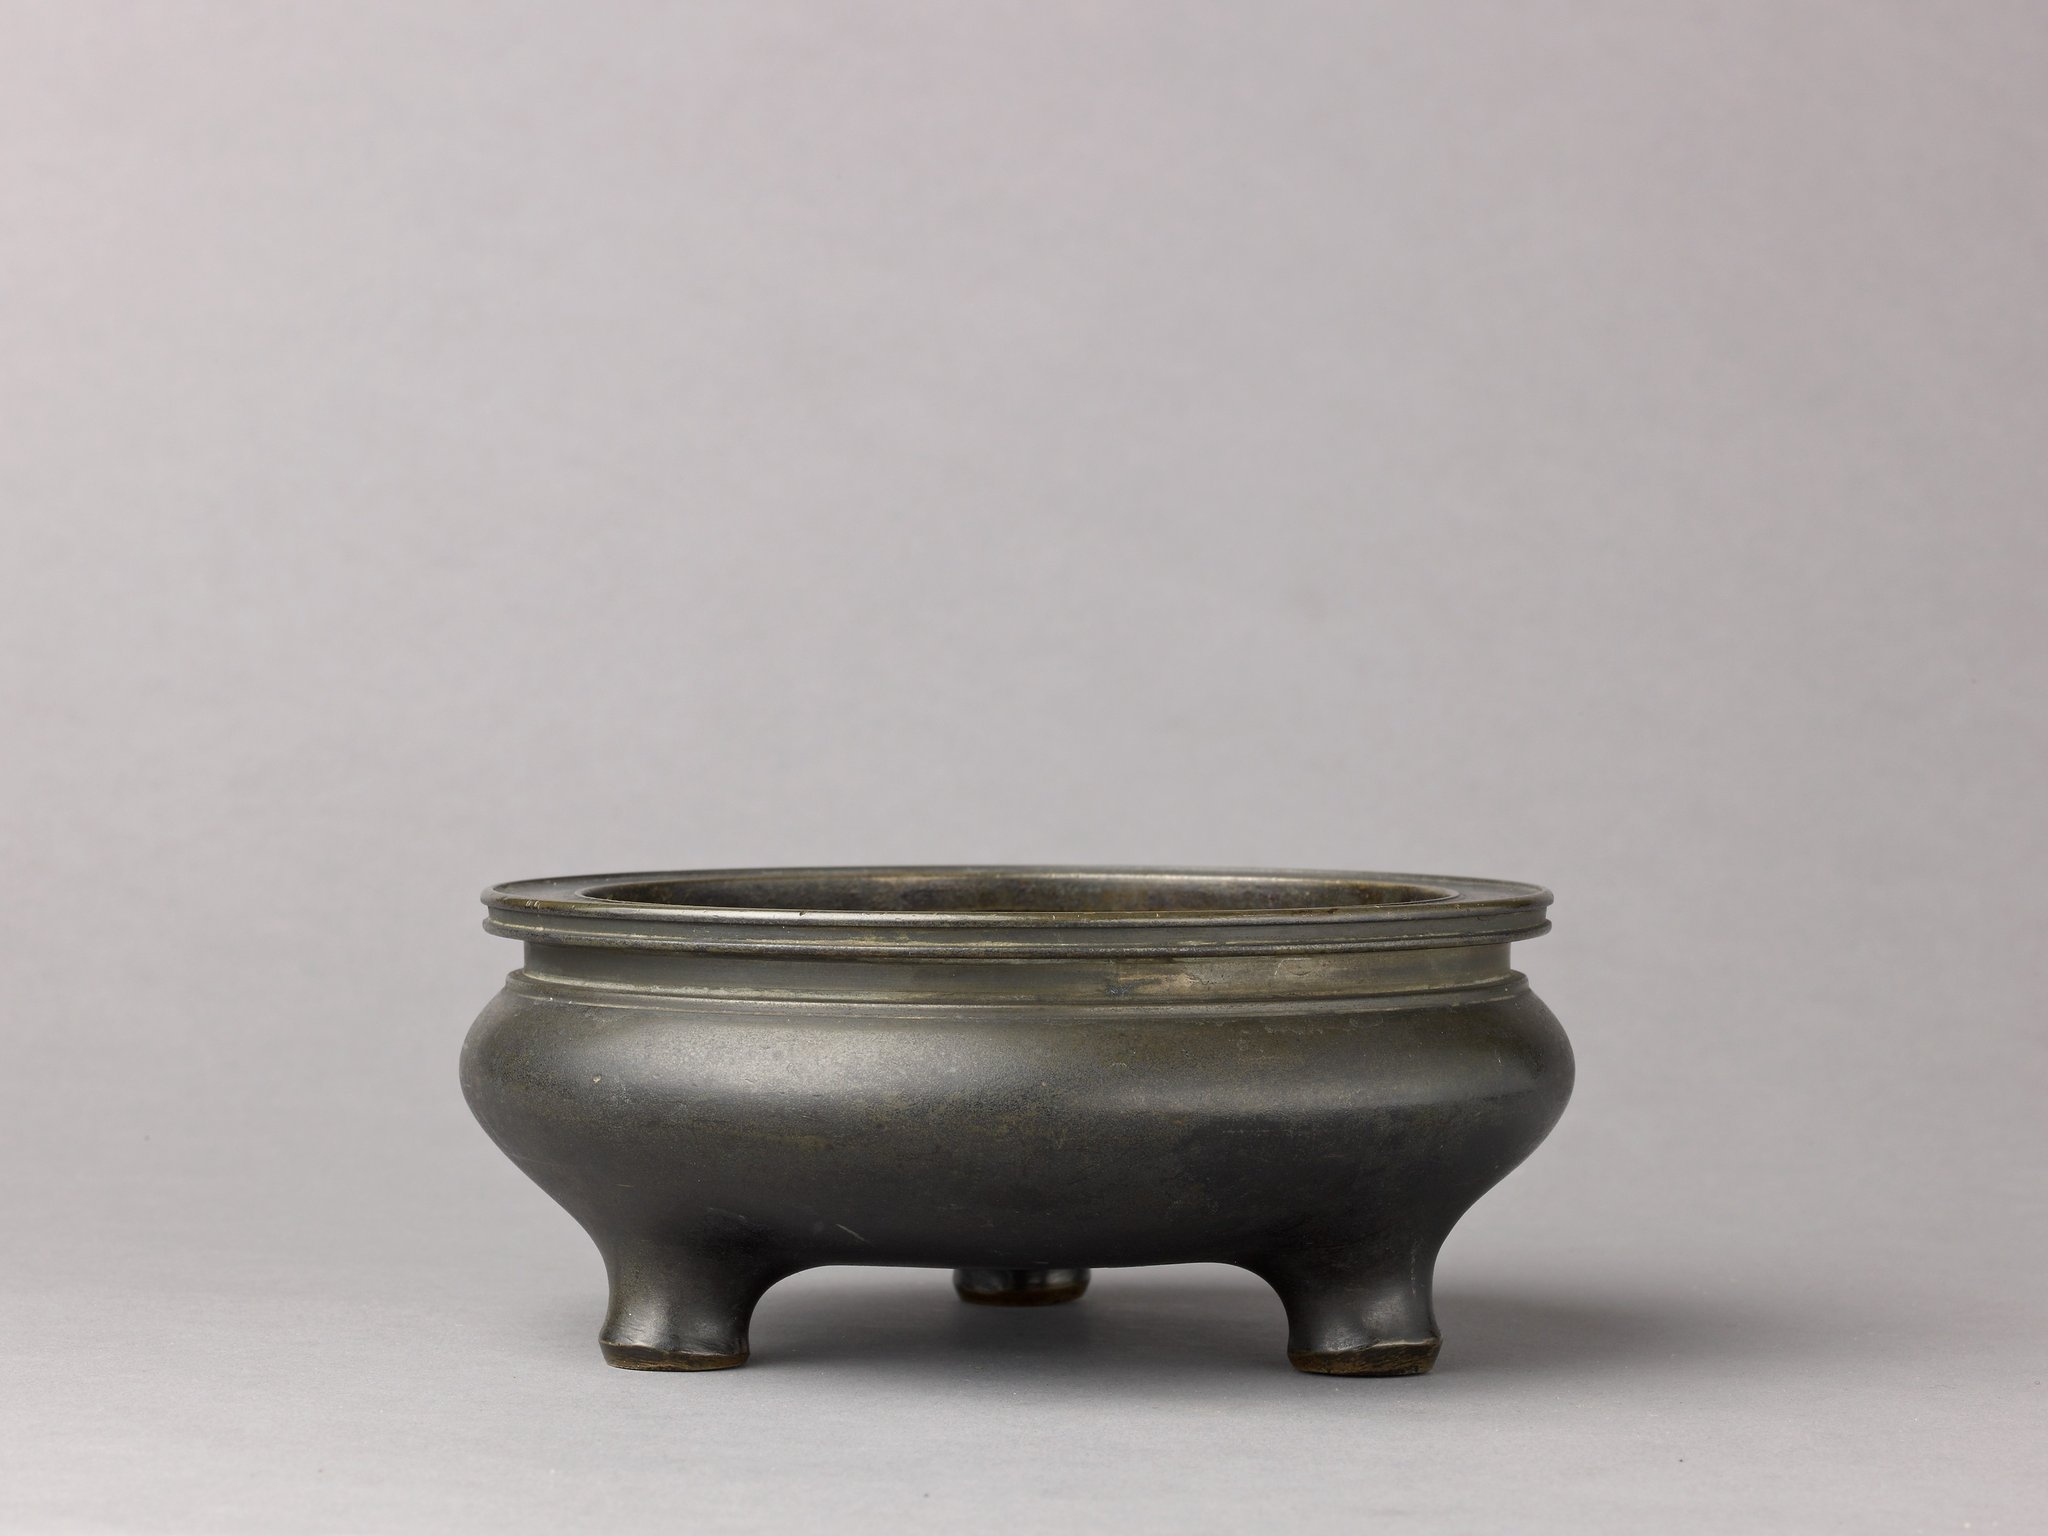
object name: censer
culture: chinese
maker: chinese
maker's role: artist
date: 1701-1800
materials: bronze